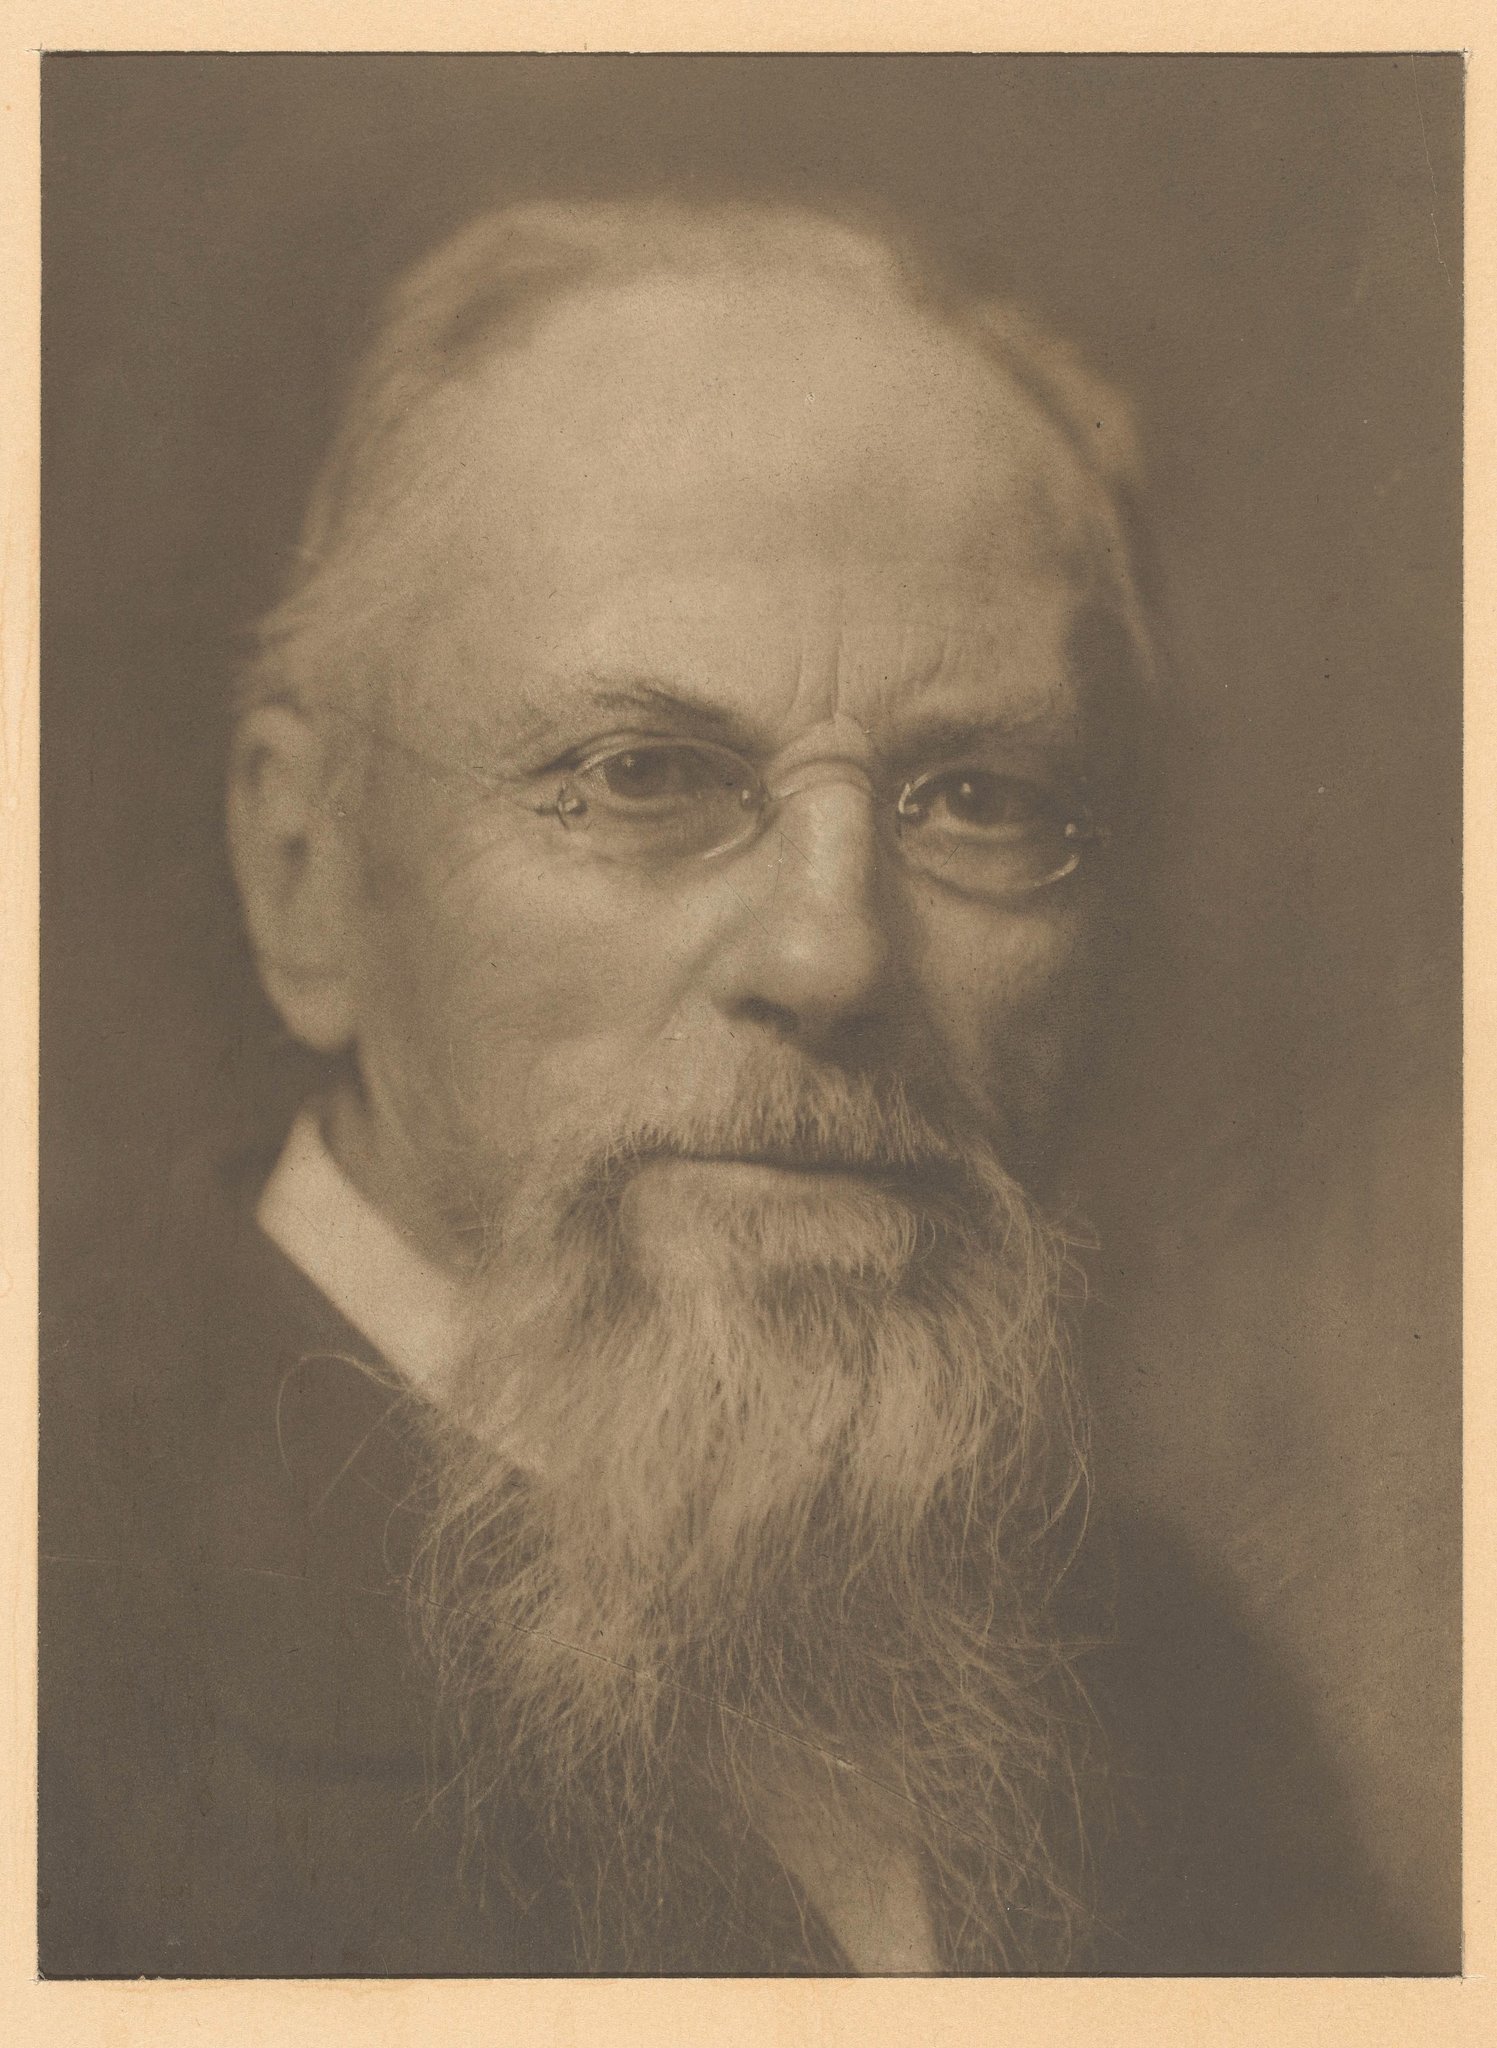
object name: photograph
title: Portret van een oude man met baard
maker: jacob merkelbach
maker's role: fotograaf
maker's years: 1877-1942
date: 1910-1930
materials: paper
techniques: gum bichromate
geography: amsterdam